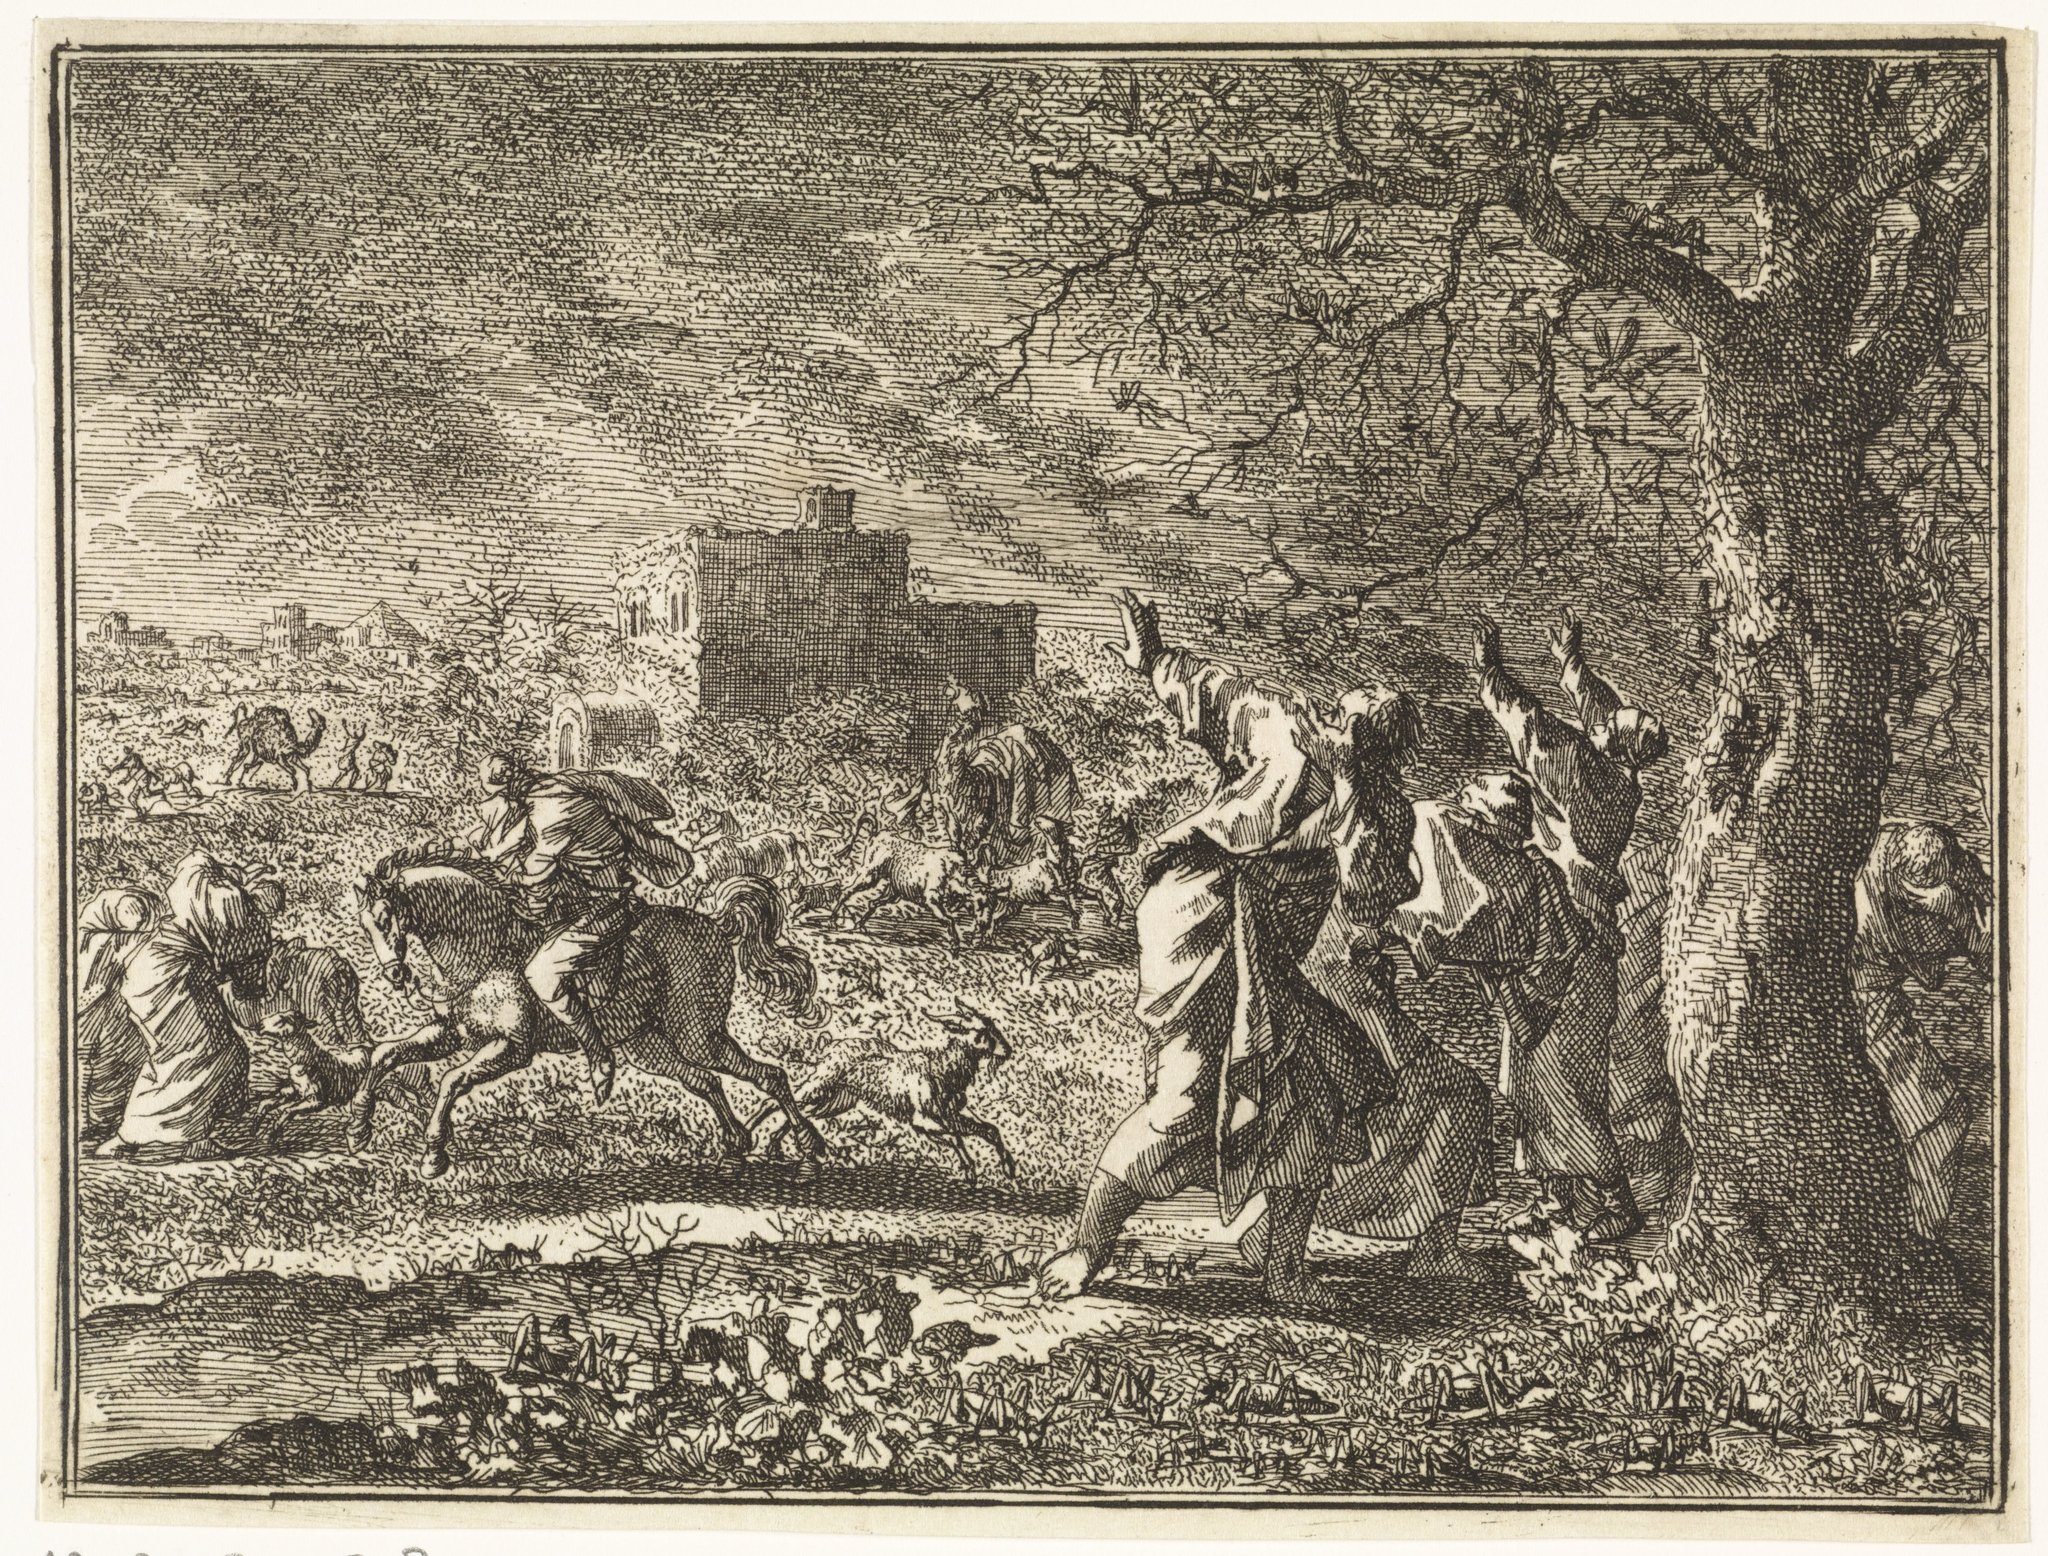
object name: print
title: Plaag van de sprinkhanen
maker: jan luyken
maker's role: draughtsman, print maker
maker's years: 1649-1712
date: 1712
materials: paper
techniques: etching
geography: amsterdam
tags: the plague of locusts: as moses raises his hands the locusts come and eat everything that has survived the hail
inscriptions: collector's mark: Lugt 2228, number: ‘57’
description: Illustratie uit: Luyken, Jan. De schriftuurlyke geschiedenissen en gelykenissen van het Oude en Nieuwe Verbond, 2 delen. Amsterdam: Wed. Pieter Arentsz II en Cornelis van der Sys, 1712, dl. I.